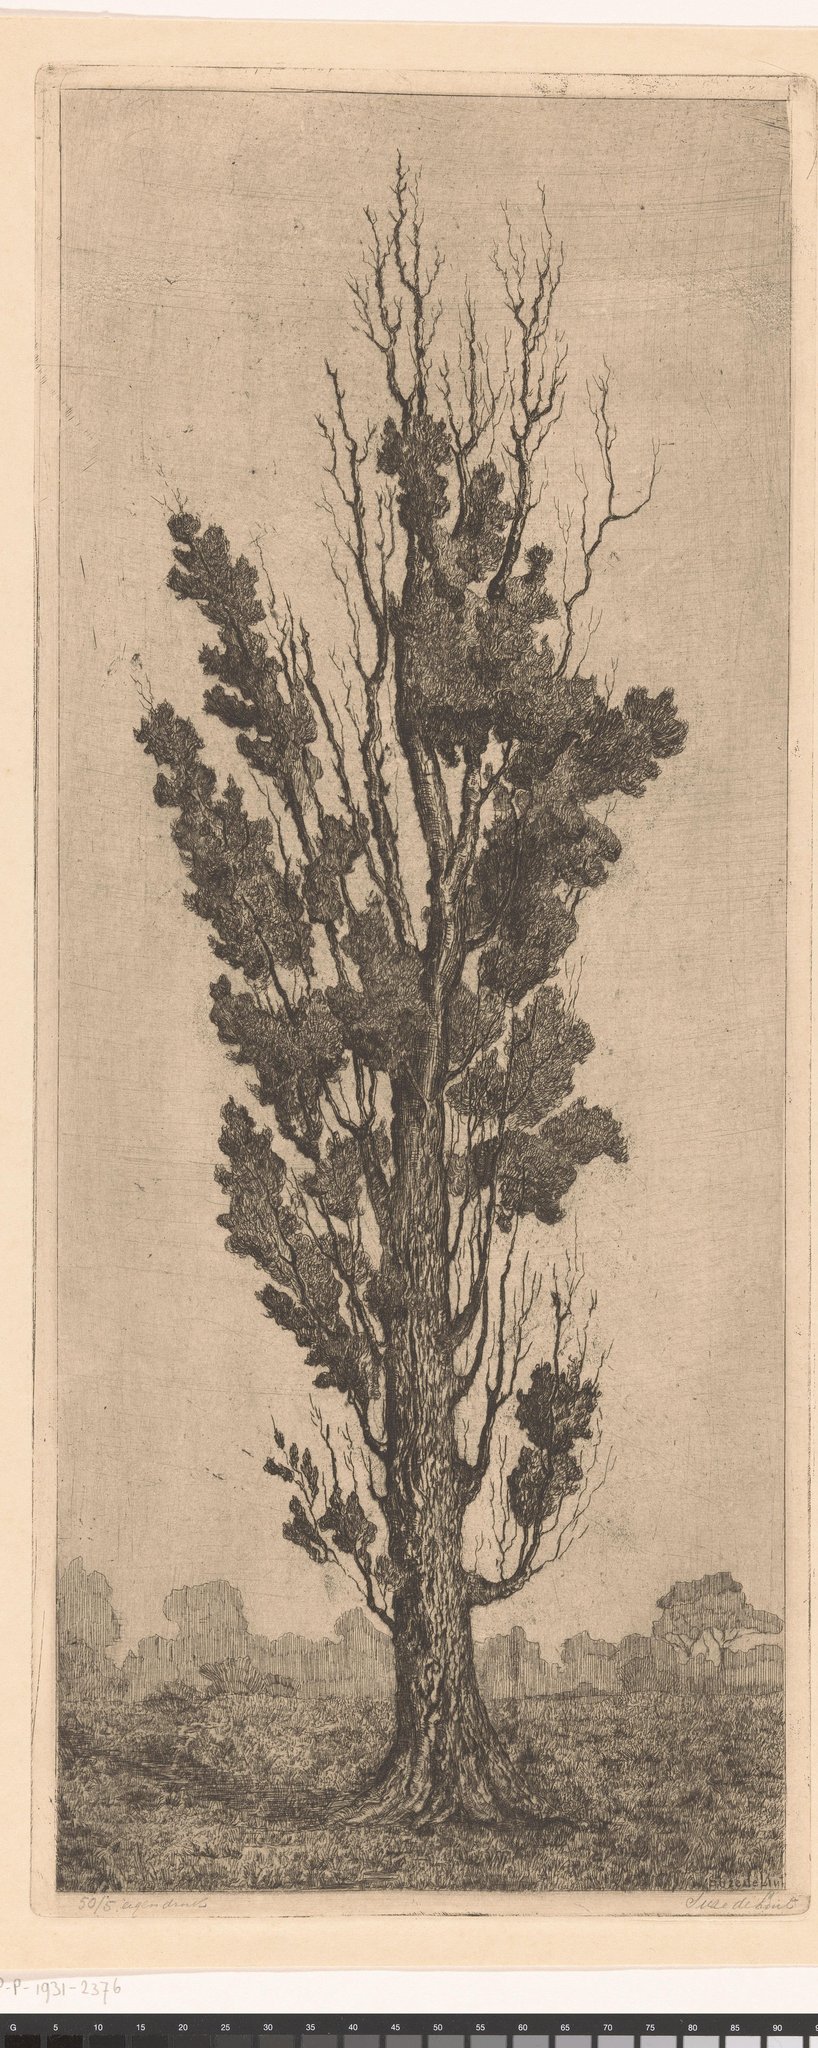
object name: print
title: Oude populier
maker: suze de lint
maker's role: print maker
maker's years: 1878-1953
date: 1888-1931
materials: paper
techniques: etching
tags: trees: poplar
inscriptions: collector's mark: Lugt 2228